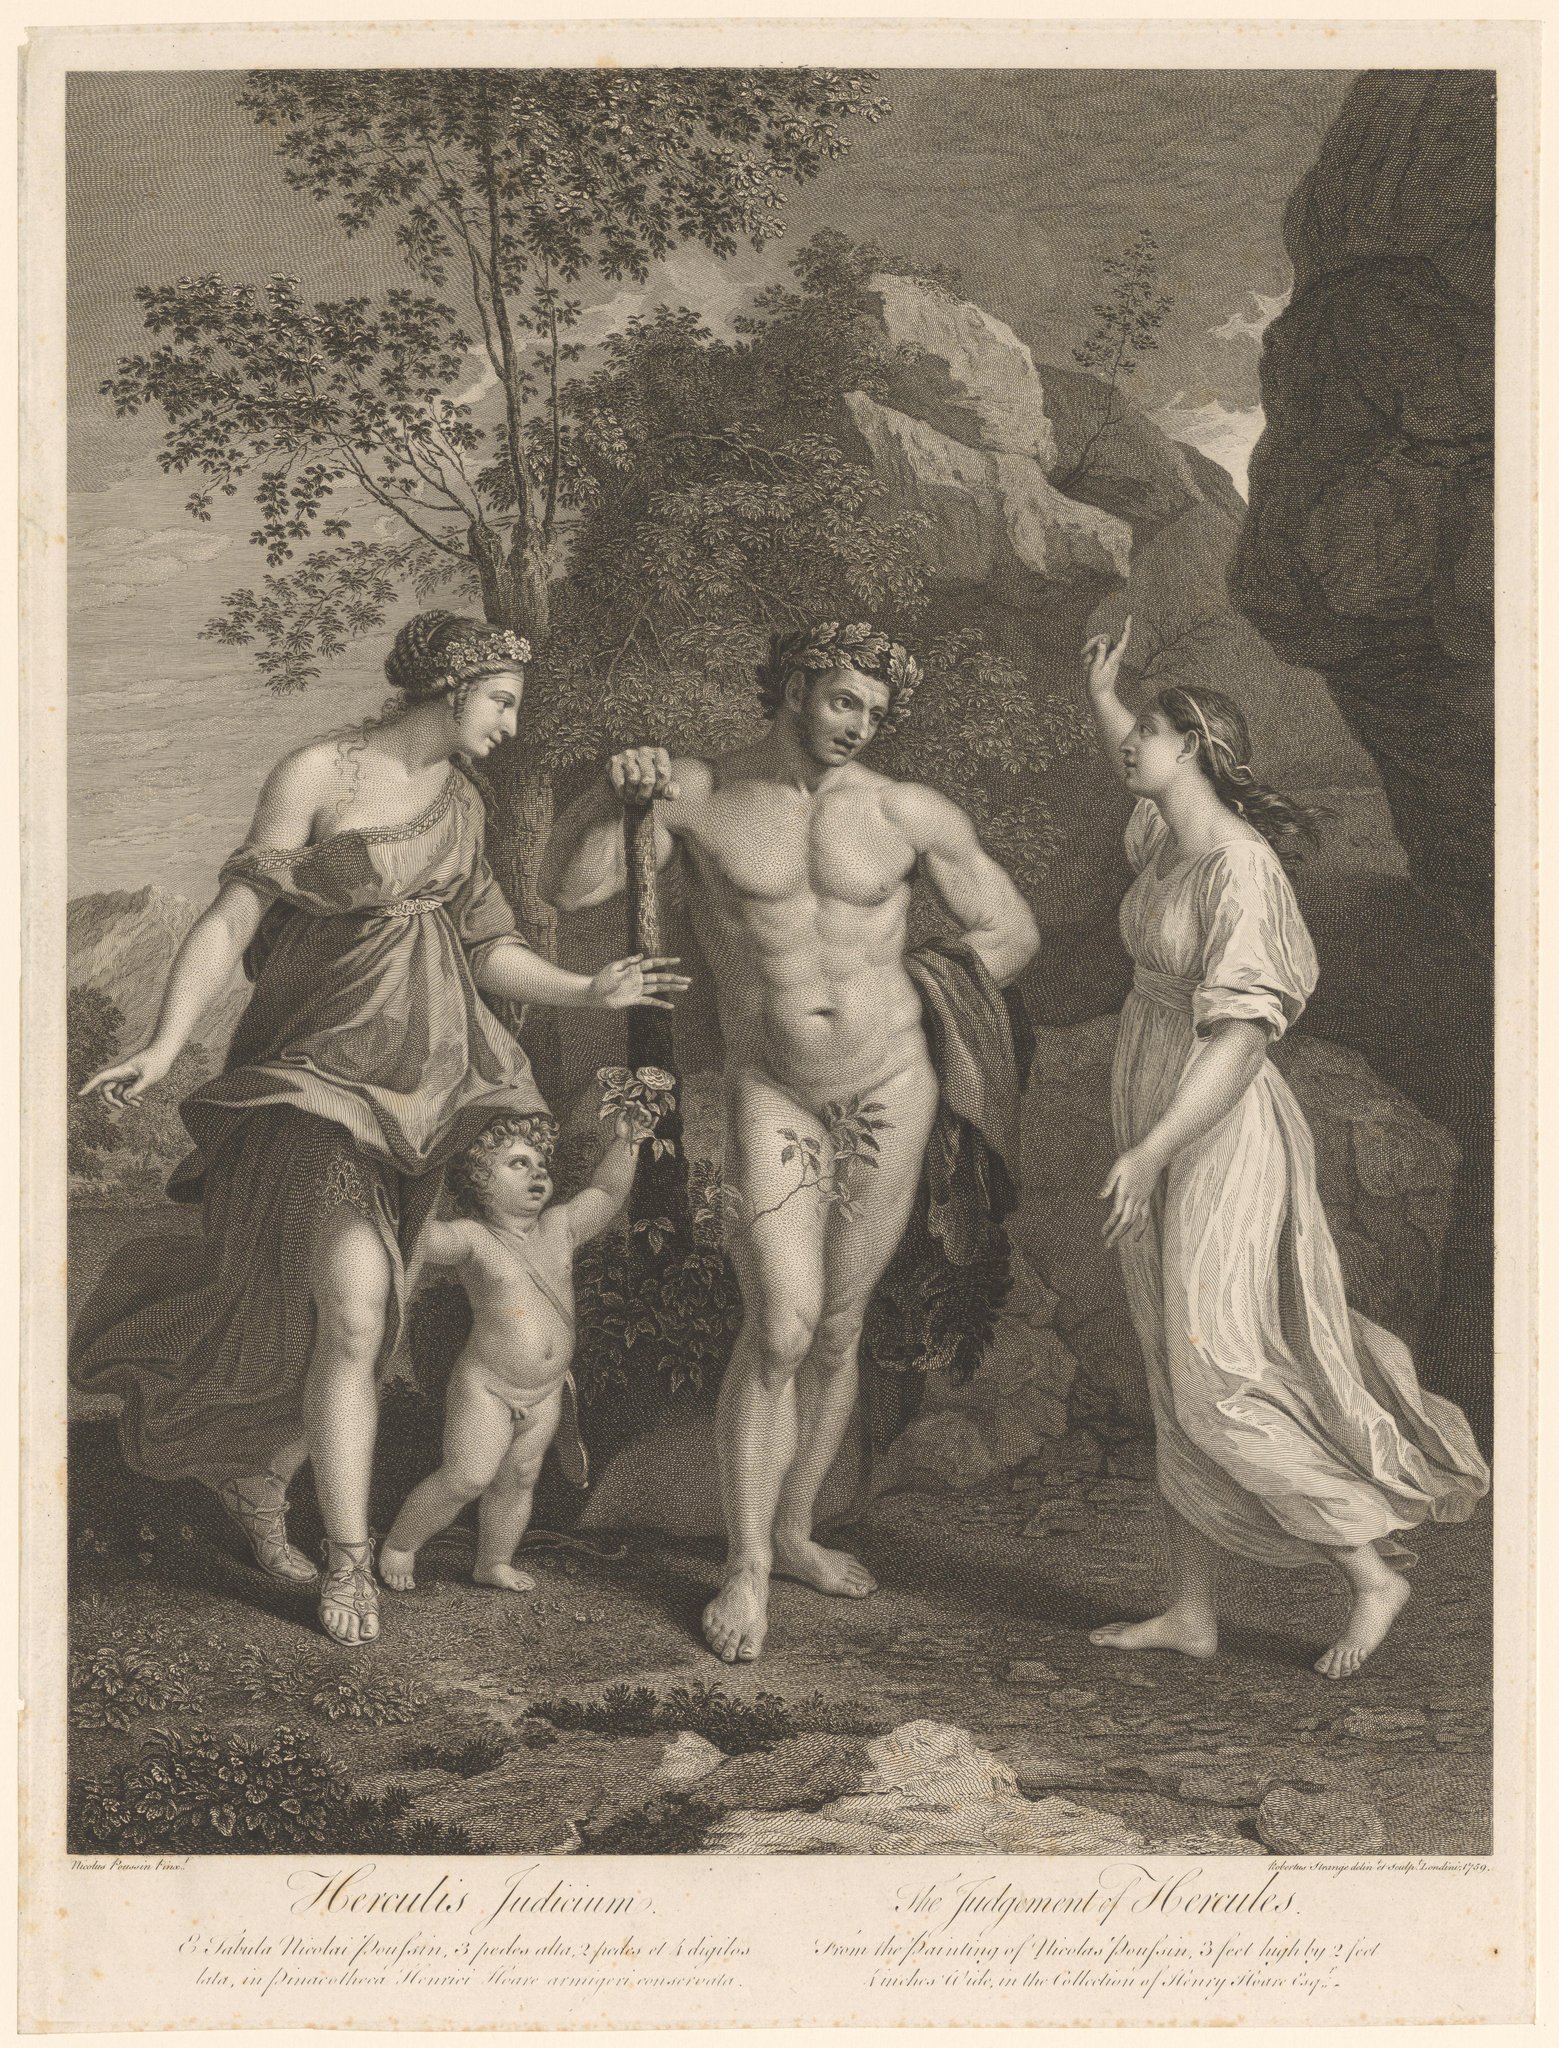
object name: print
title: Hercules tussen Deugd en Ondeugd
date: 1759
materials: paper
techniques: engraving, etching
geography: london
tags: (story of) hercules (heracles), strife between virtues and vices, psychomachy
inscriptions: date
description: Hercules moet kiezen tussen de Ondeugd en de Deugd, twee vrouwelijke personificaties die links en rechts van hem staan. De Ondeugd wijst naar beneden en biedt hem een prettig en eenvoudig leven. De Deugd wijst omhoog, en biedt hem een leven vol ontberingen, maar met roem.